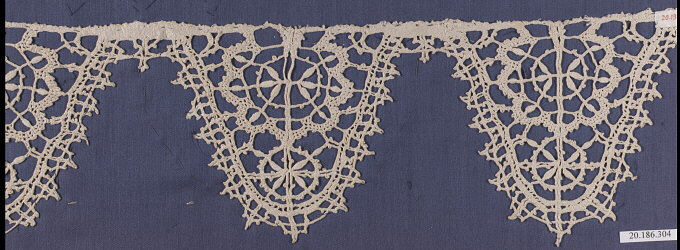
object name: edging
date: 1601-1700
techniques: lace